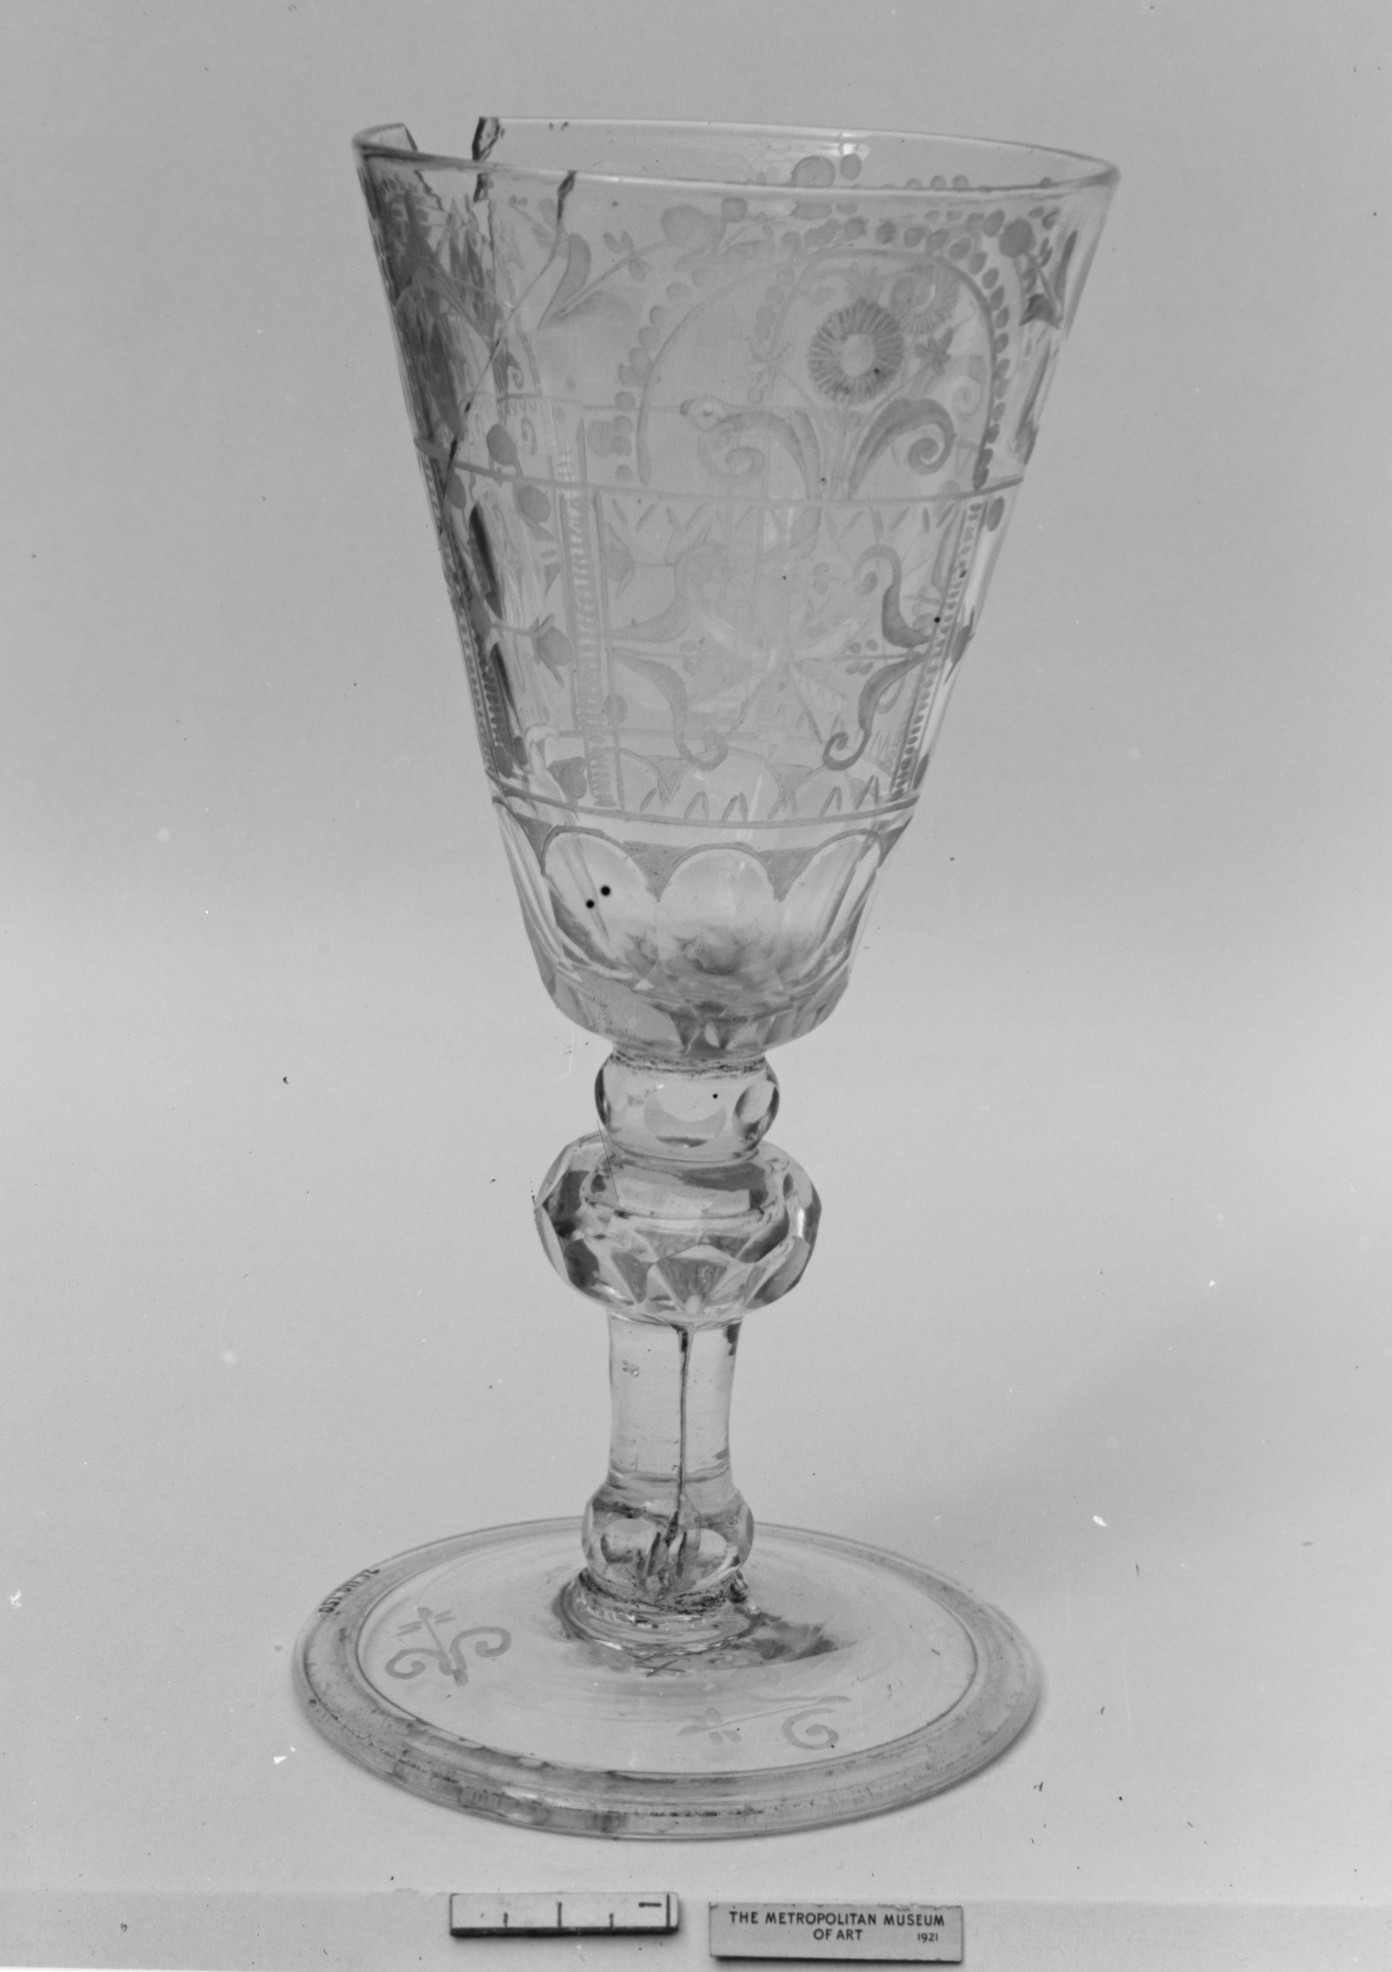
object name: wineglass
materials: glass